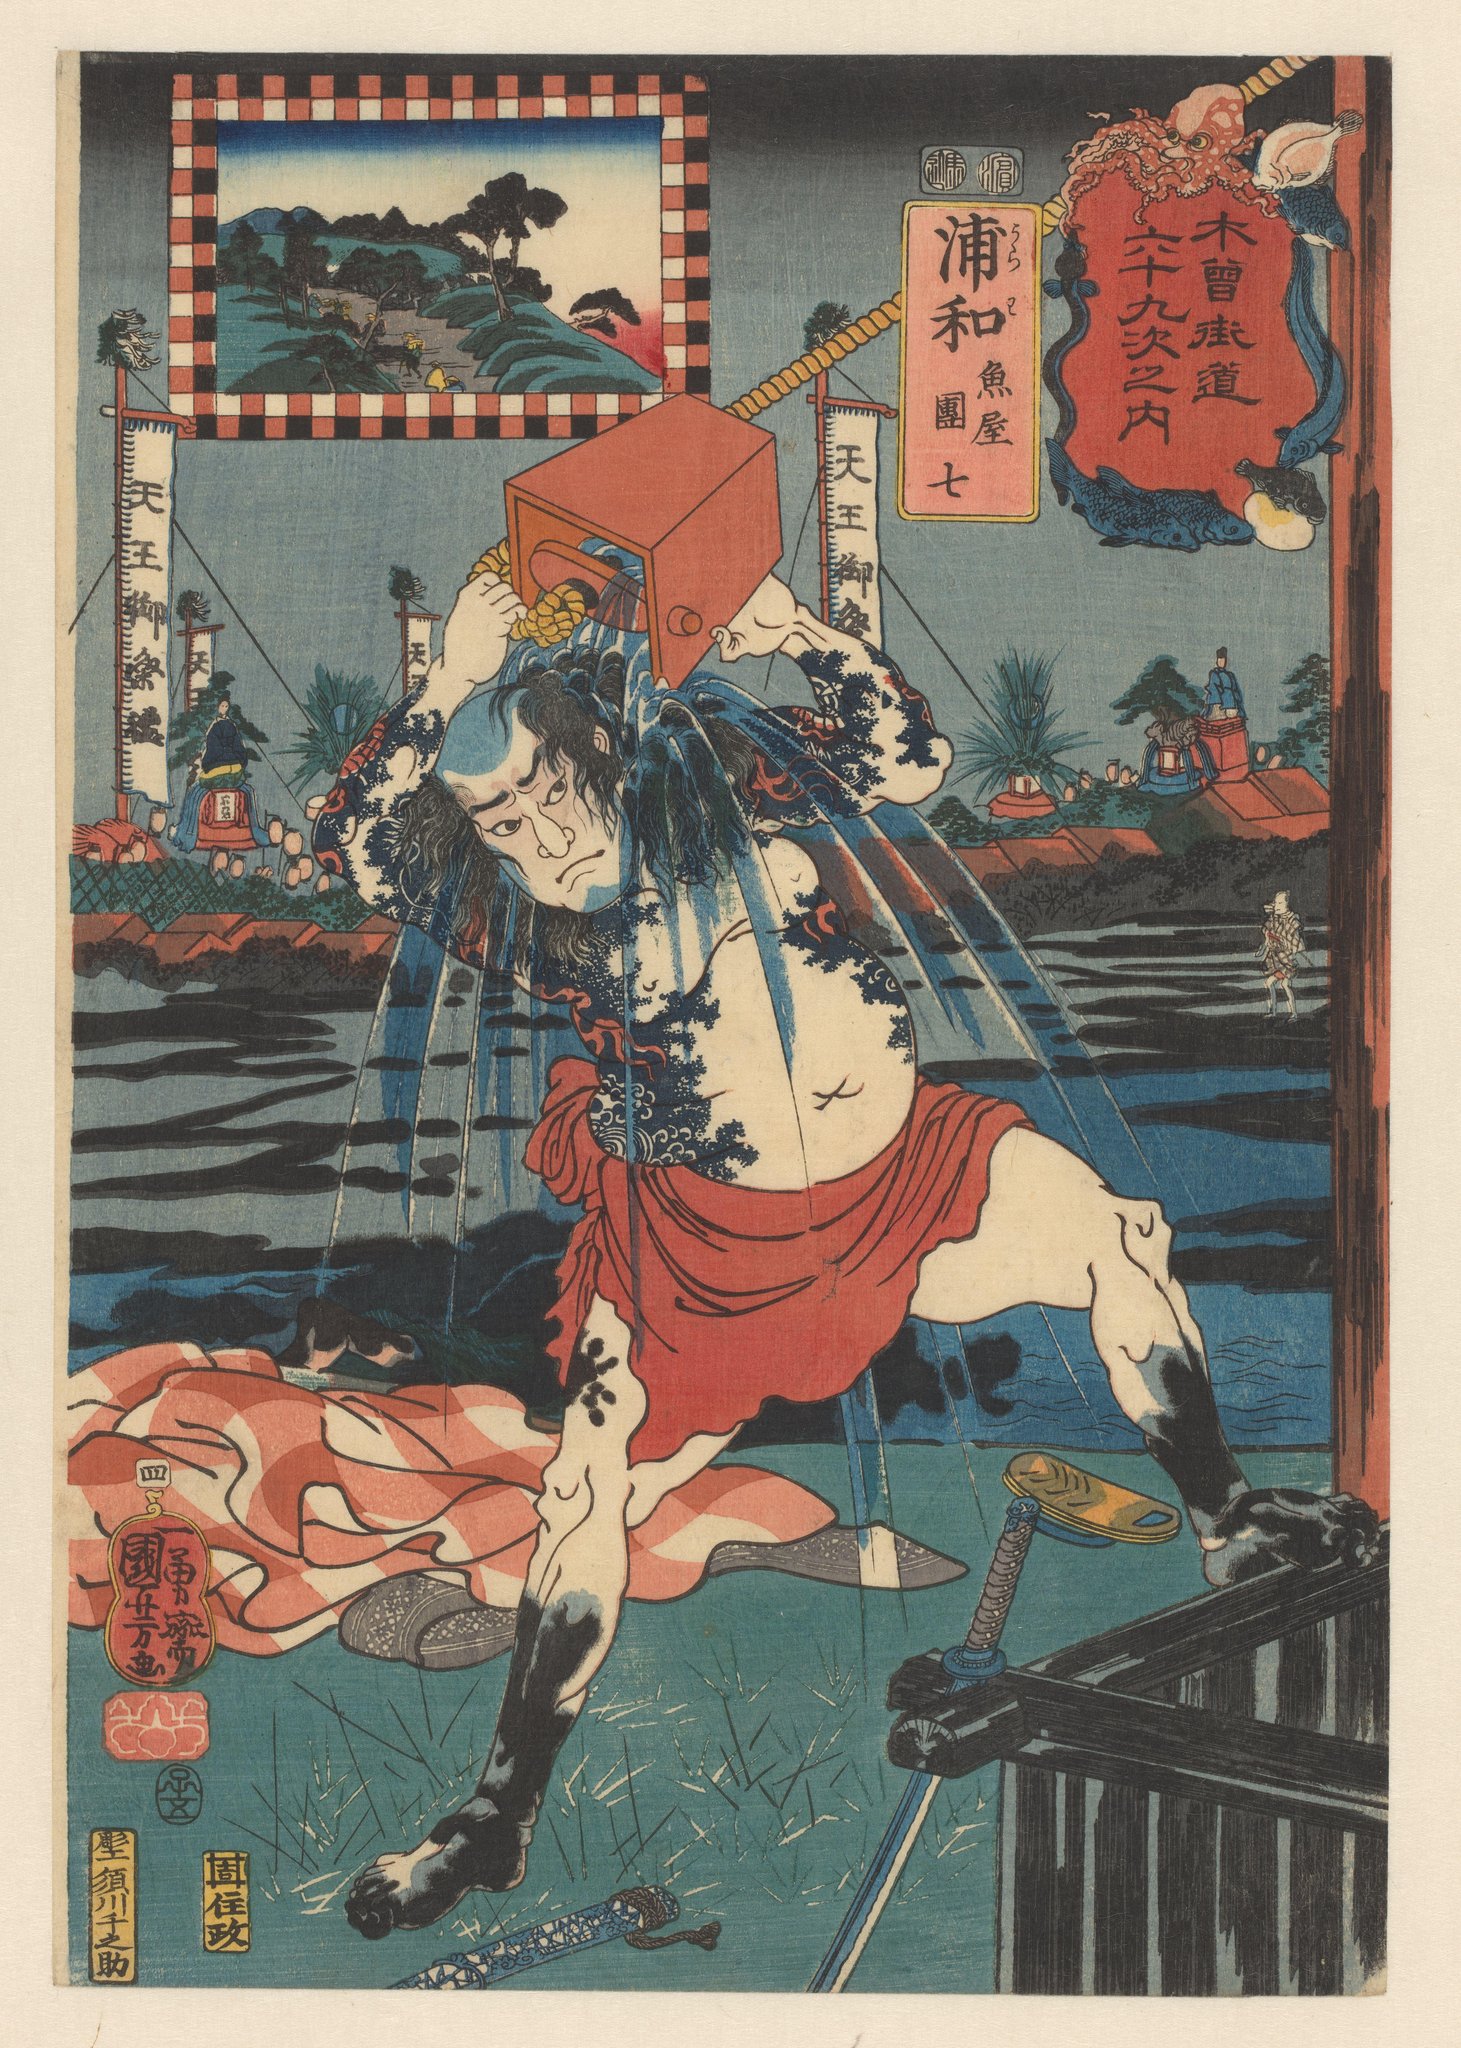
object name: print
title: Danshichi Kurobei pouring himself with water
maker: utagawa kuniyoshi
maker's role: draughtsman, print maker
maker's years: 1798-1861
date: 1849-1852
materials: paper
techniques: woodcut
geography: japan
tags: adult man, washing and bathing - aa - in the open air, water course (+ landscape with figures, staffage)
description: De getatoeëerde visverkoper Danshichi Kurobei gooit een emmer water over zich heen, om zichzelf te reinigen nadat hij zijn schoonvader Giheiji heeft vermoord.